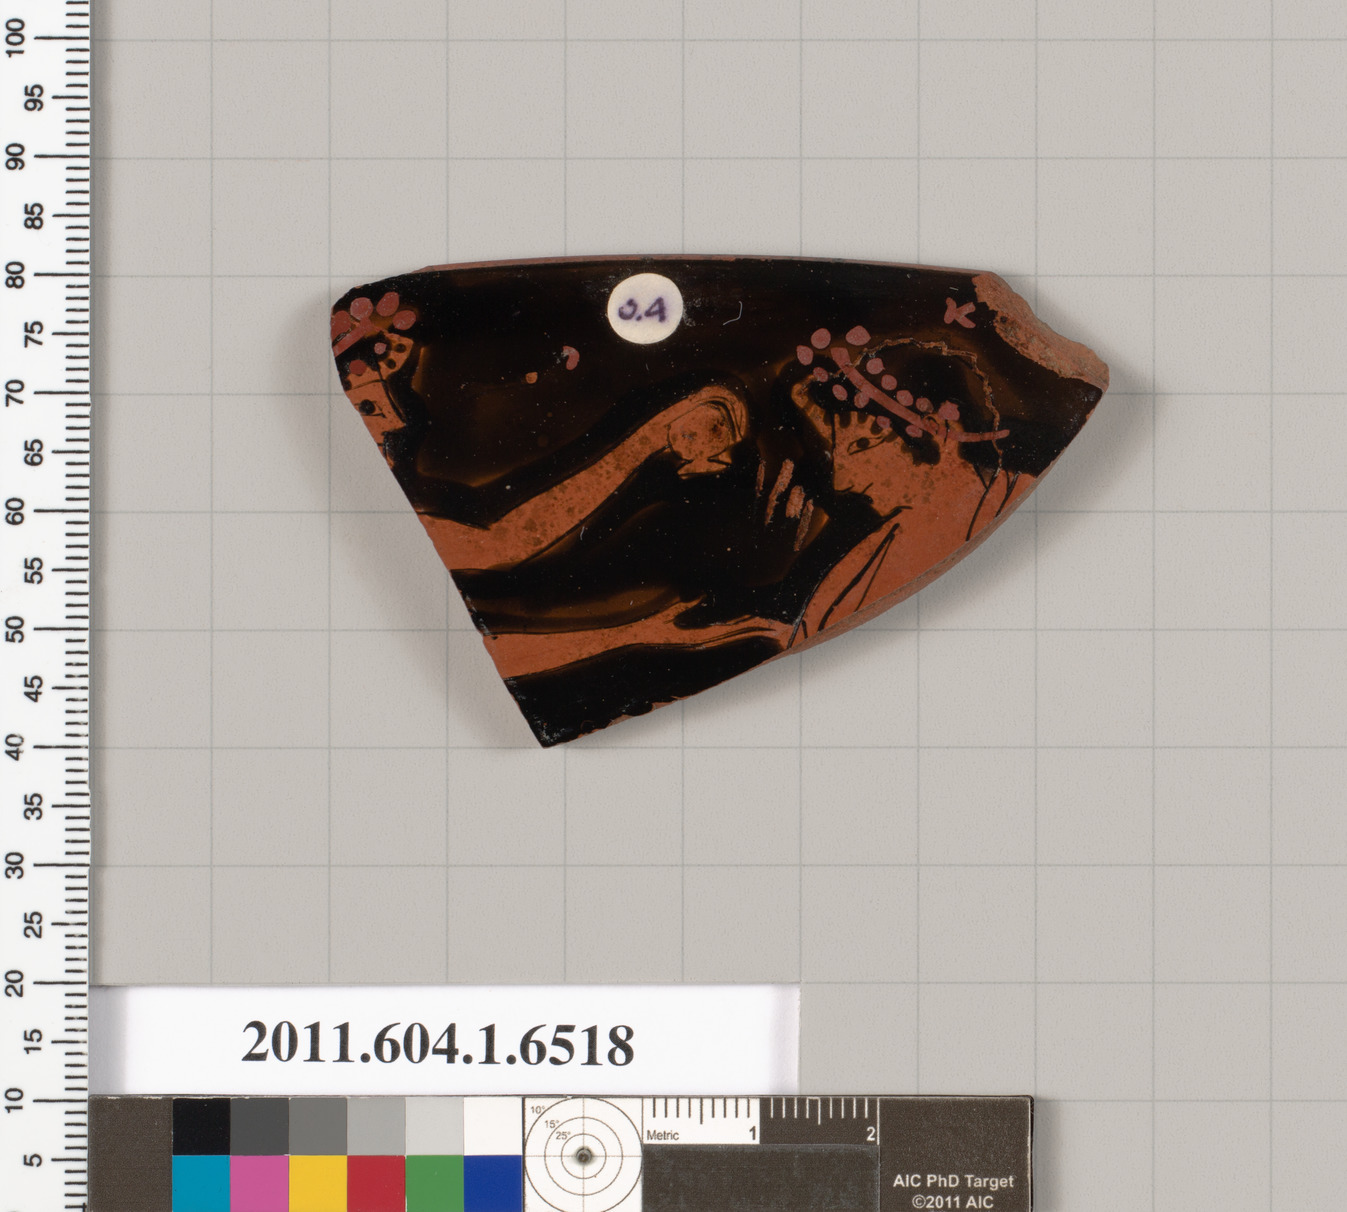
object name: kylix fragment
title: Terracotta rim fragment of a kylix (drinking cup)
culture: greek, attic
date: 490-480 BCE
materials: terracotta